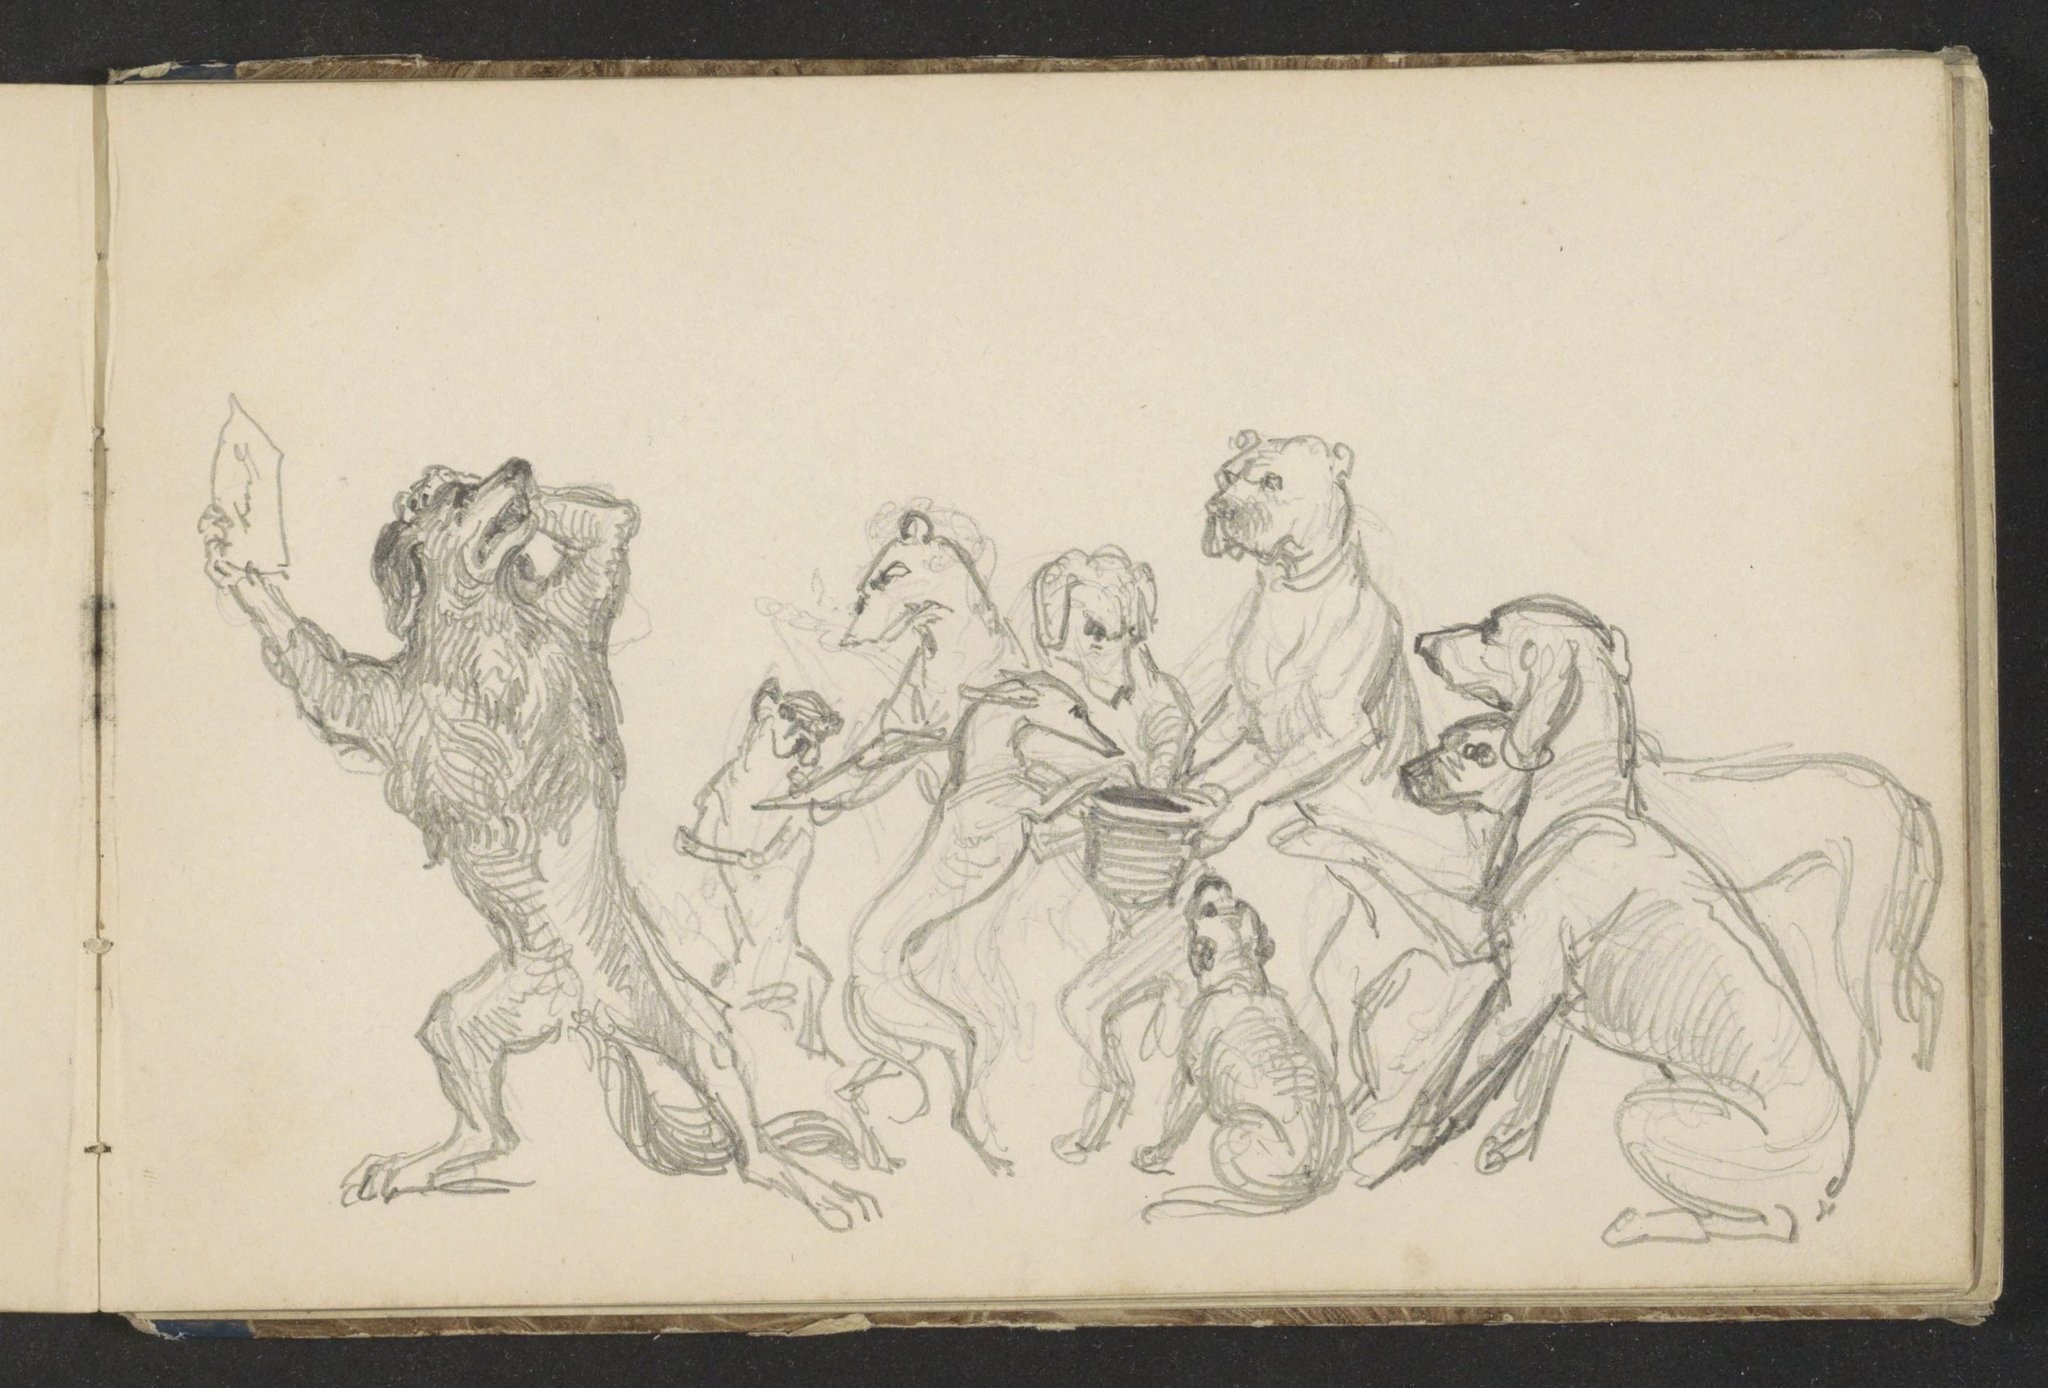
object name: sketchbook leaf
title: Roedel honden rond een hoge hoed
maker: Anonymous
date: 1841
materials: paper, pencil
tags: dog, head-gear: top hat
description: Een deel van de honden kijkt op naar een hond met een brief of pamflet in zijn poot. Blad 13 recto uit een schetsboek met 33 bladen.